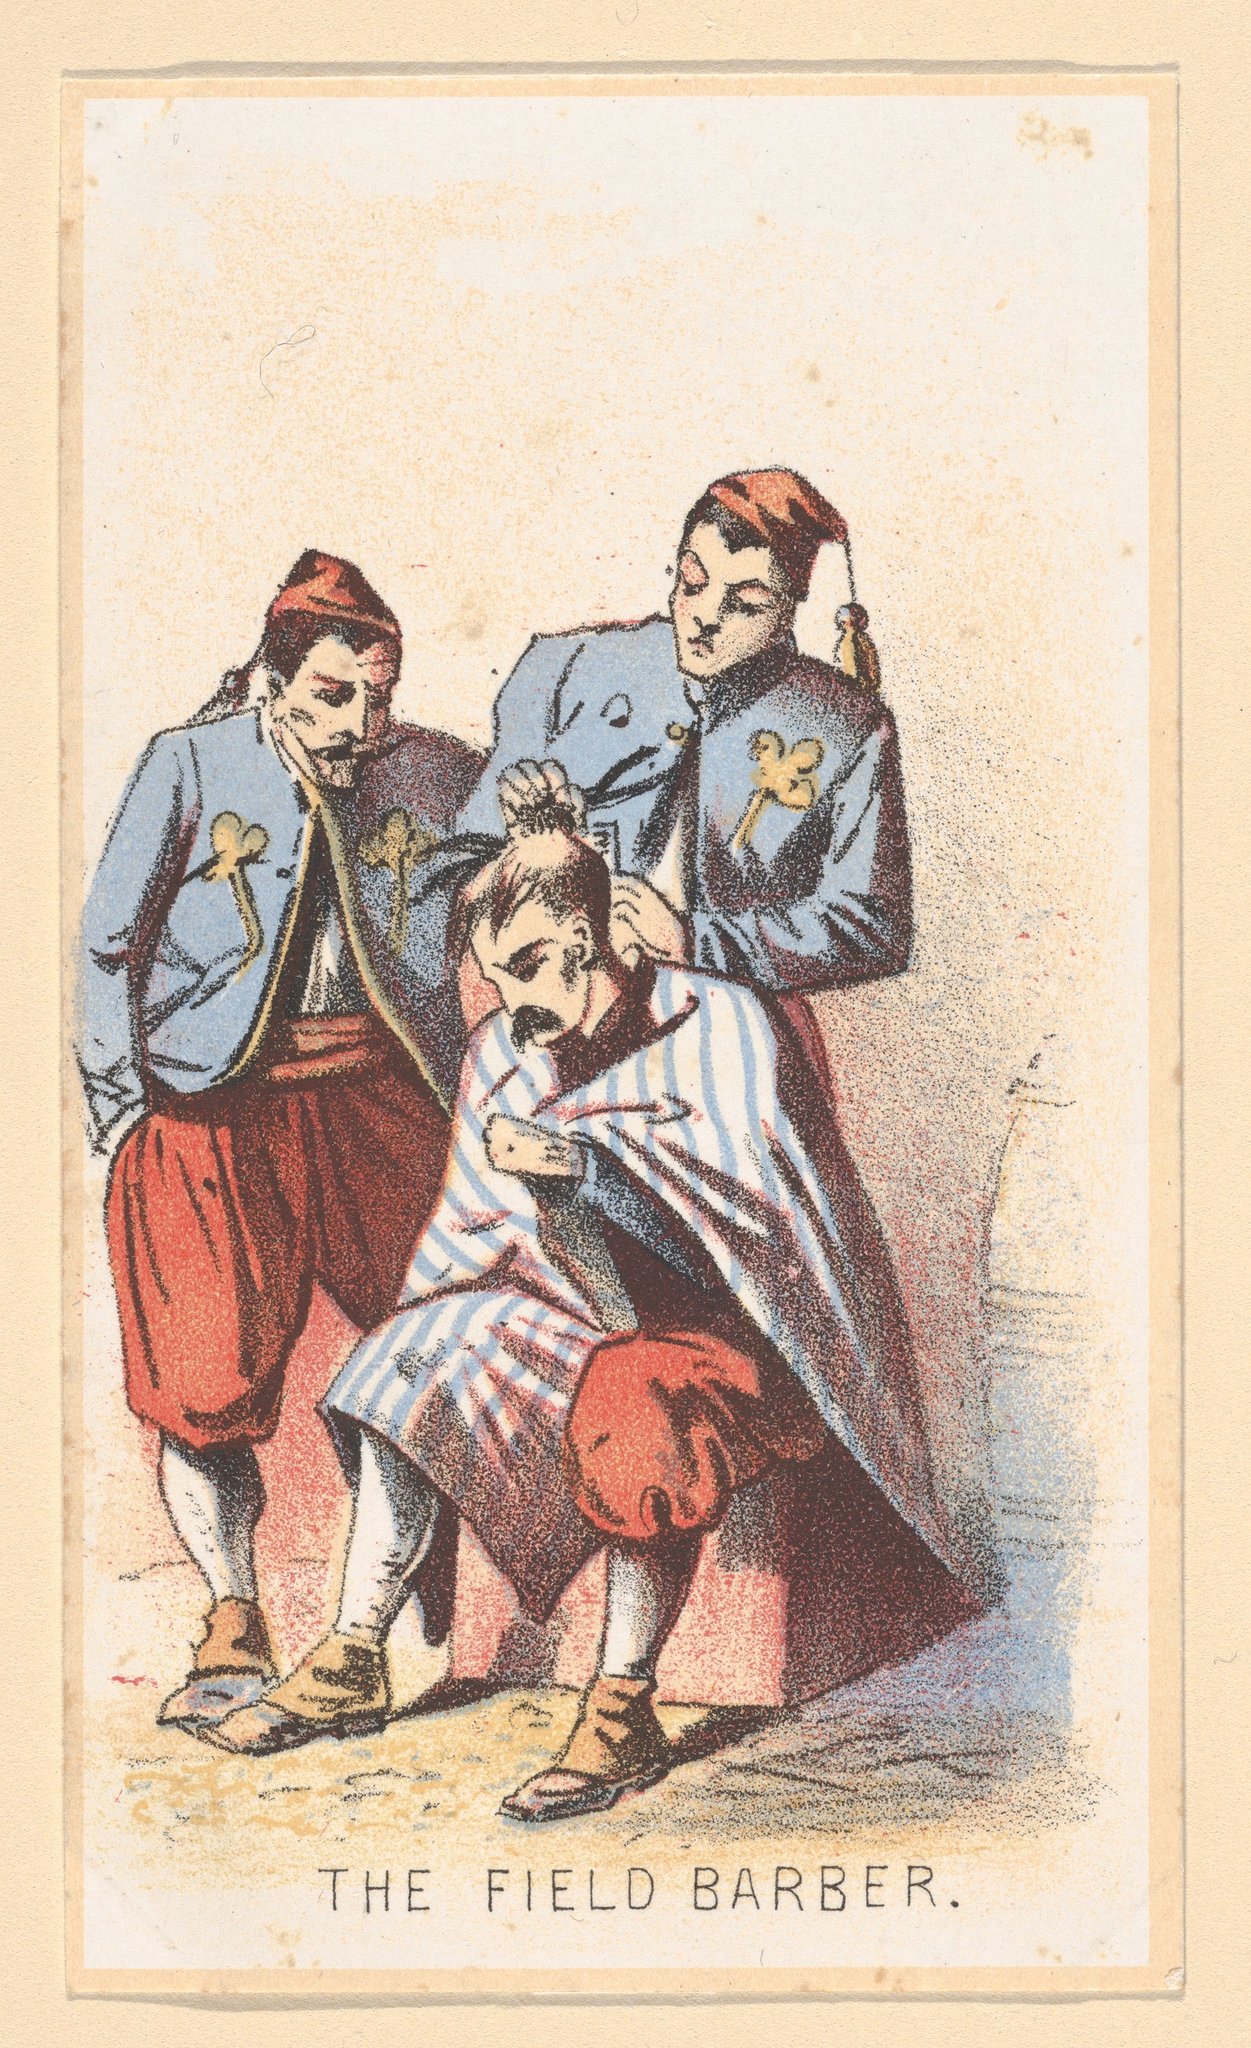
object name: print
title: Life in Camp, Part 2: The Field Barber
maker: winslow homer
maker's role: artist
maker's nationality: american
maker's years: 1836-1910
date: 1864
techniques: lithograph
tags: soldiers,american civil war,men